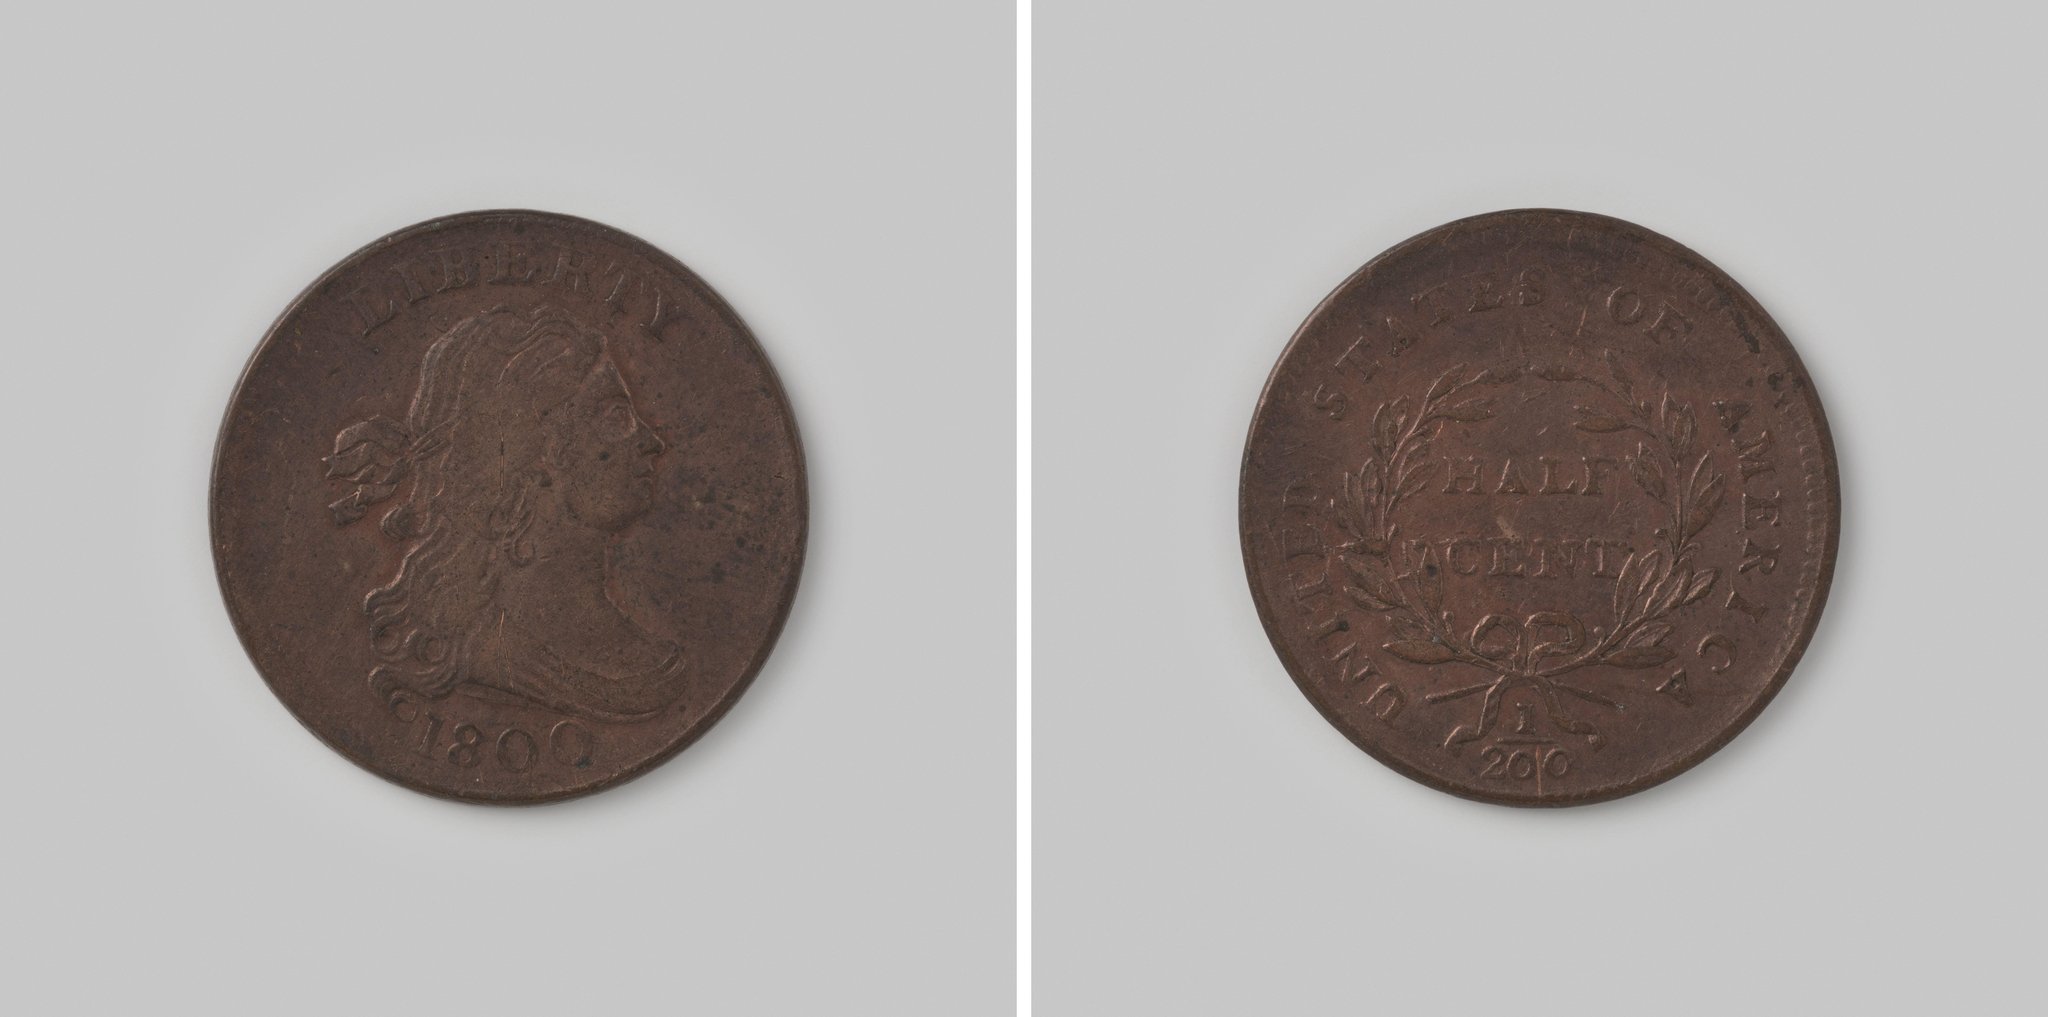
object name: coin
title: Verenigde Staten van Amerika, ½ cent, 1800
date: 1800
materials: copper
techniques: striking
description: Koperen munt. Voorzijde: liberty (draped bust) naar rechts. Onderaan jaartal. Keerzijde: tussen twee met grote strik samengebonden takken waarde-aanduiding: half cent in twee regels. Onderaan tussen linten waarde-aanduiding: 1/200. Gladde rand.